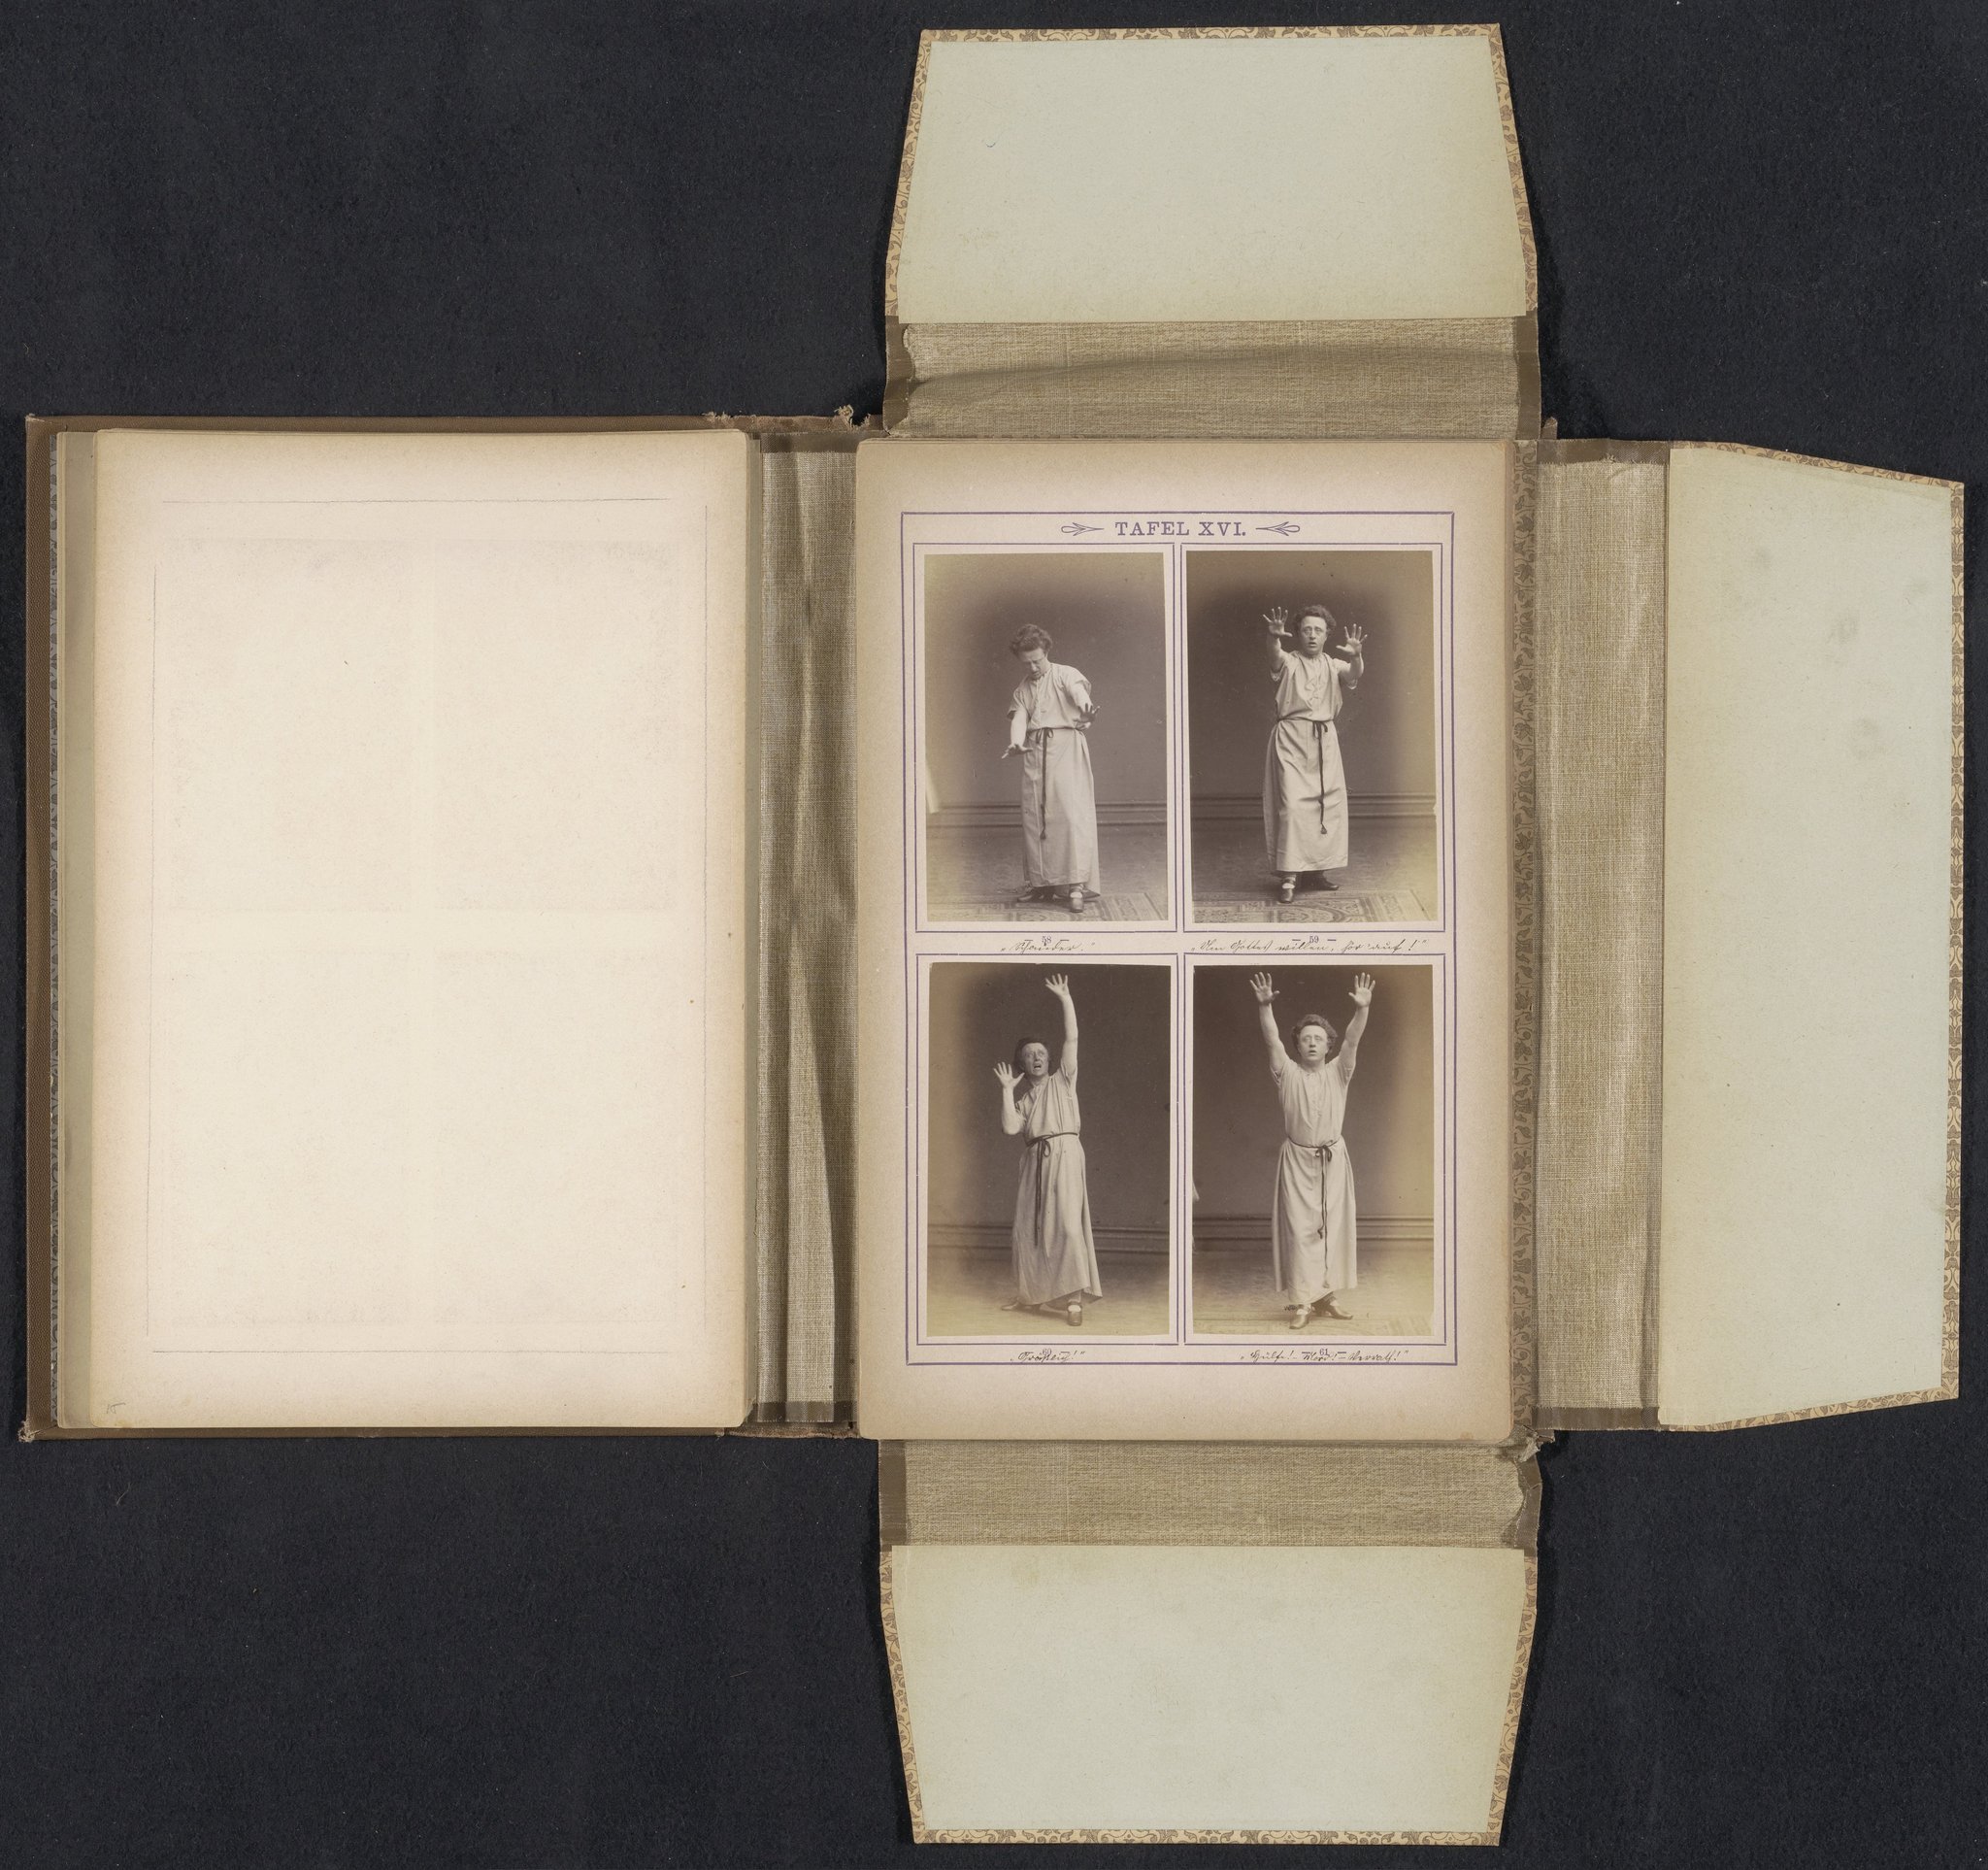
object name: photograph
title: Portretten van een man in vier poses met gestrekte armen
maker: nicola tonger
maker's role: fotograaf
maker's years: 1846-1917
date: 1881-1886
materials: cardboard, photographic support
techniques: albumen print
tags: gesture-language, arm raised upward, arm stretched sidewards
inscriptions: number: ‘58 (...) 61’, inscription: ‘,,Schauder'' (...) Verrat" und ähnliche Ausrufe.’, number: ‘Tafel XVI.’